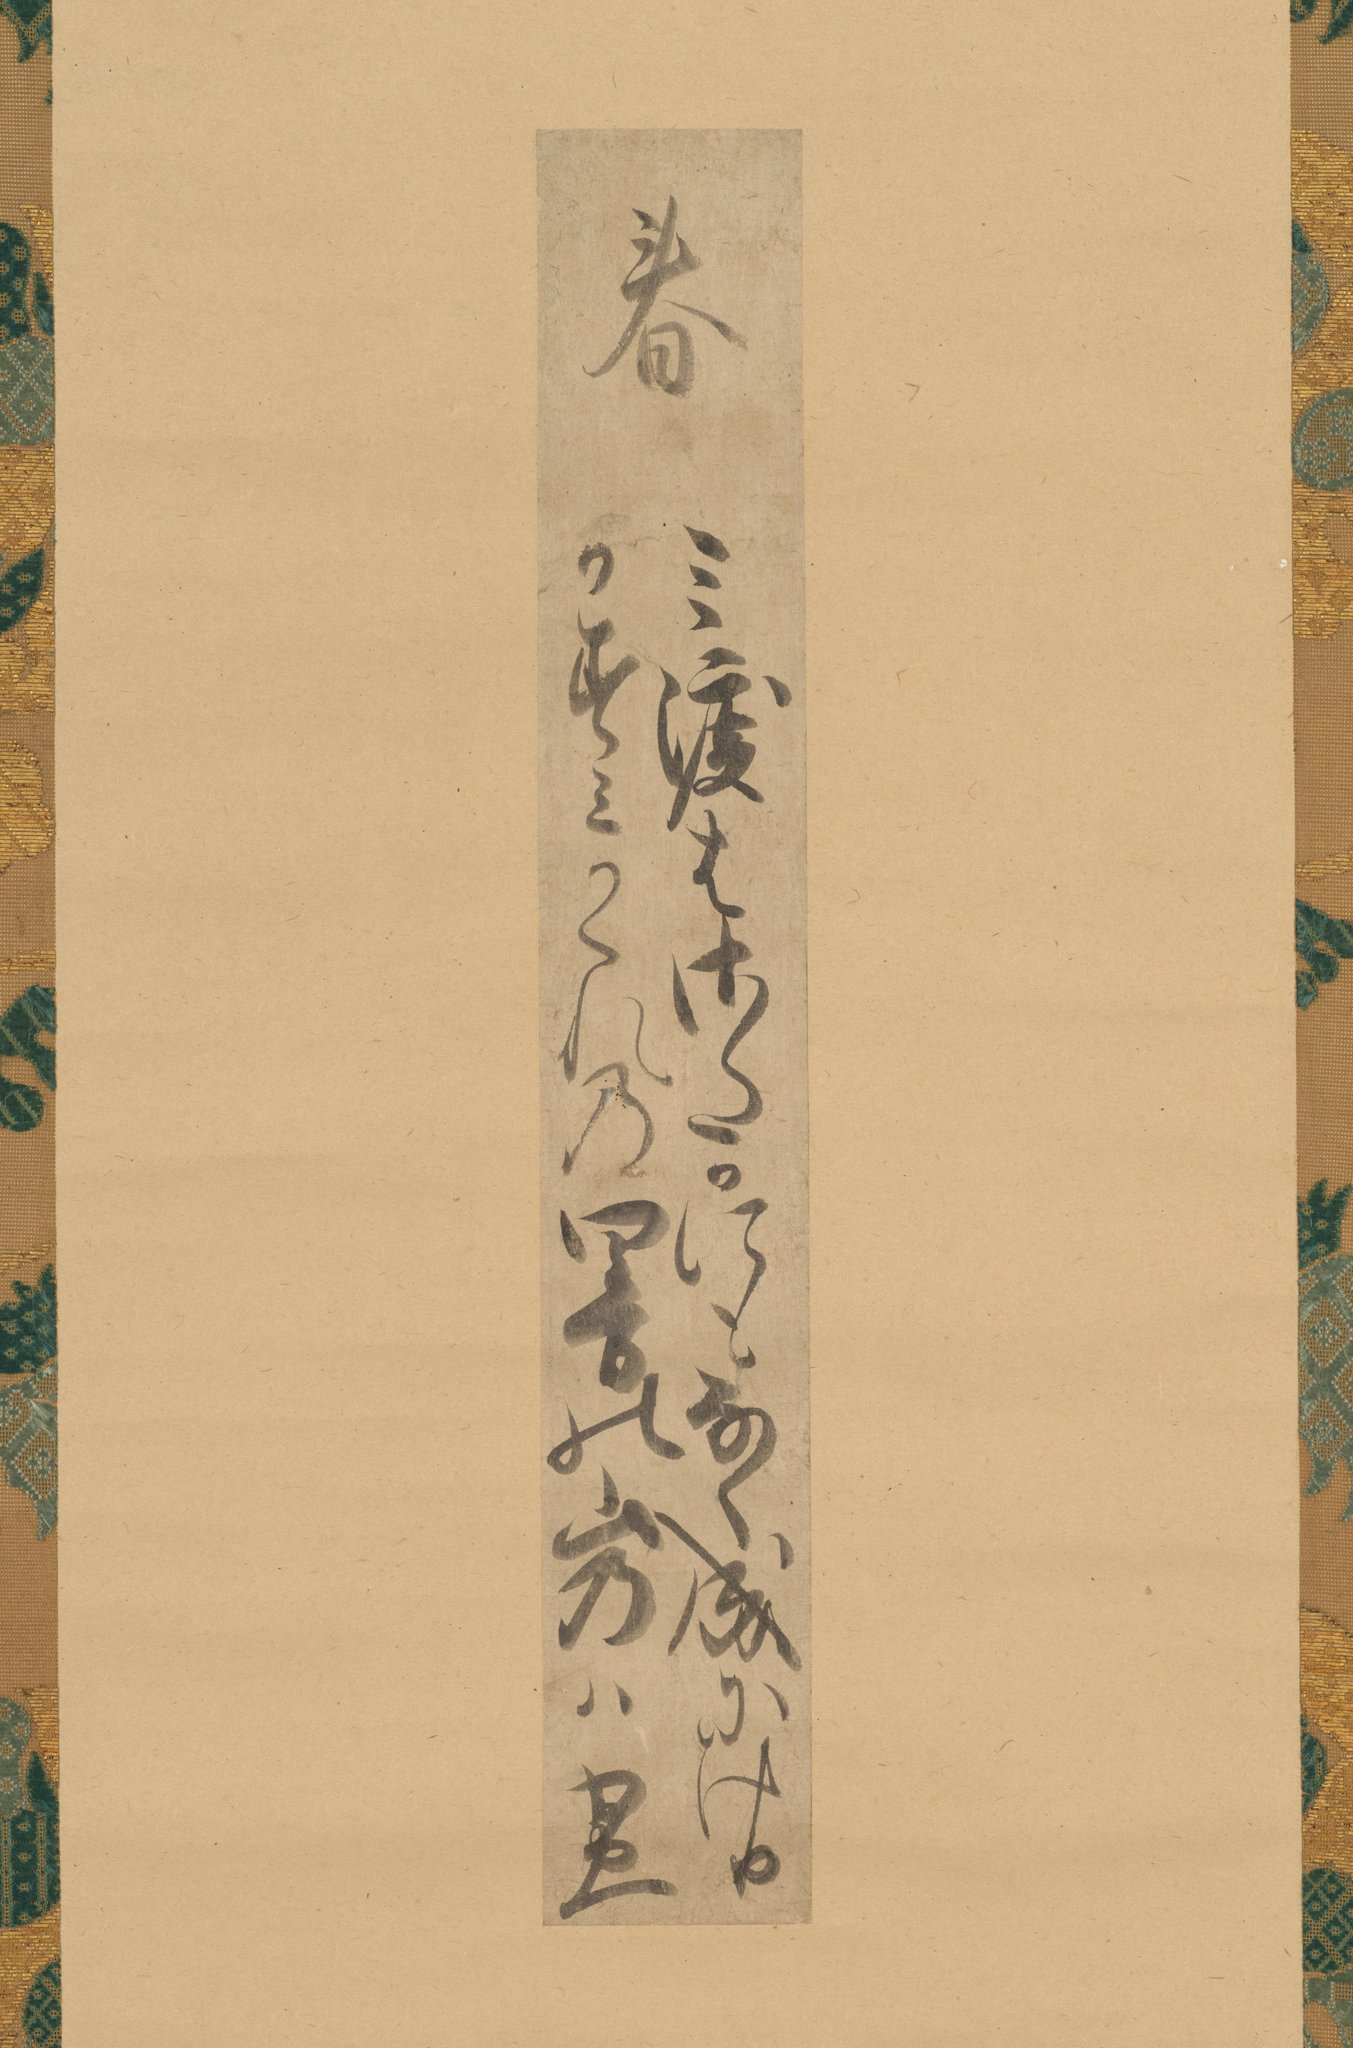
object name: hanging scroll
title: “Spring” Waka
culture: japanese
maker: nijō tametada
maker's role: artist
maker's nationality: japanese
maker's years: 1309-1373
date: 1334-1366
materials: ink, paper